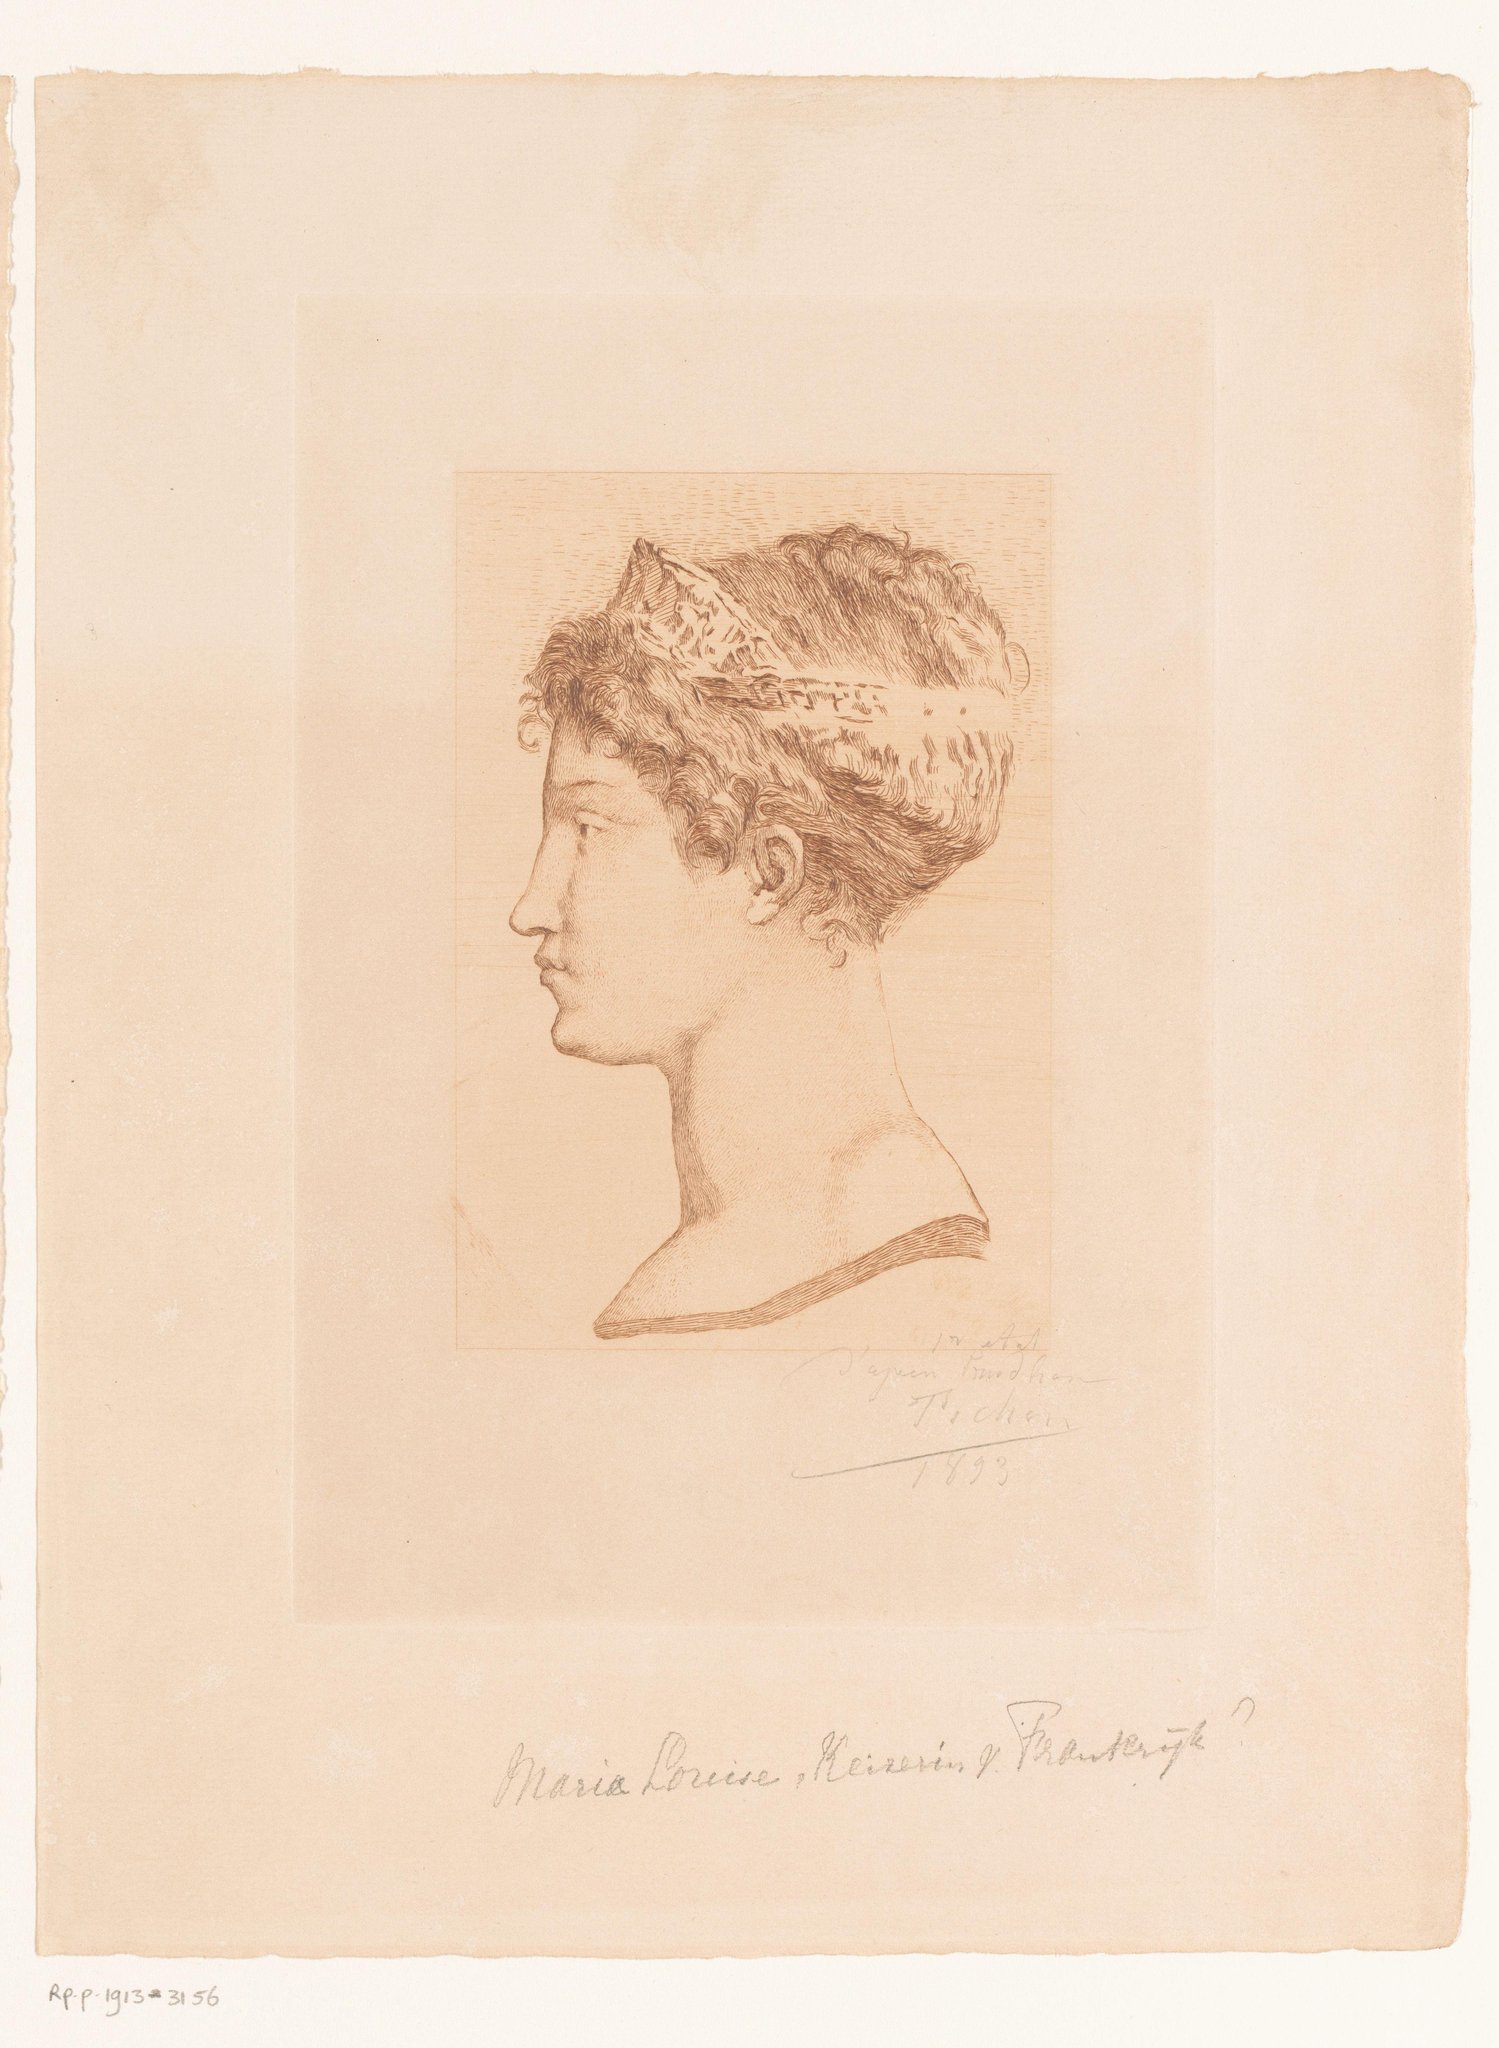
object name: print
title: Portret van Marie Louise van Oostenrijk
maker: charles tichon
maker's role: draughtsman, painter, print maker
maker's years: 1865-1924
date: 1893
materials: paper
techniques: etching, intaglio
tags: marie louise van oostenrijk (keizerin der fransen), adult woman, historical persons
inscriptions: collector's mark: Lugt 2228, inscription: ‘1e etat; d'apres prudhon; 1893’